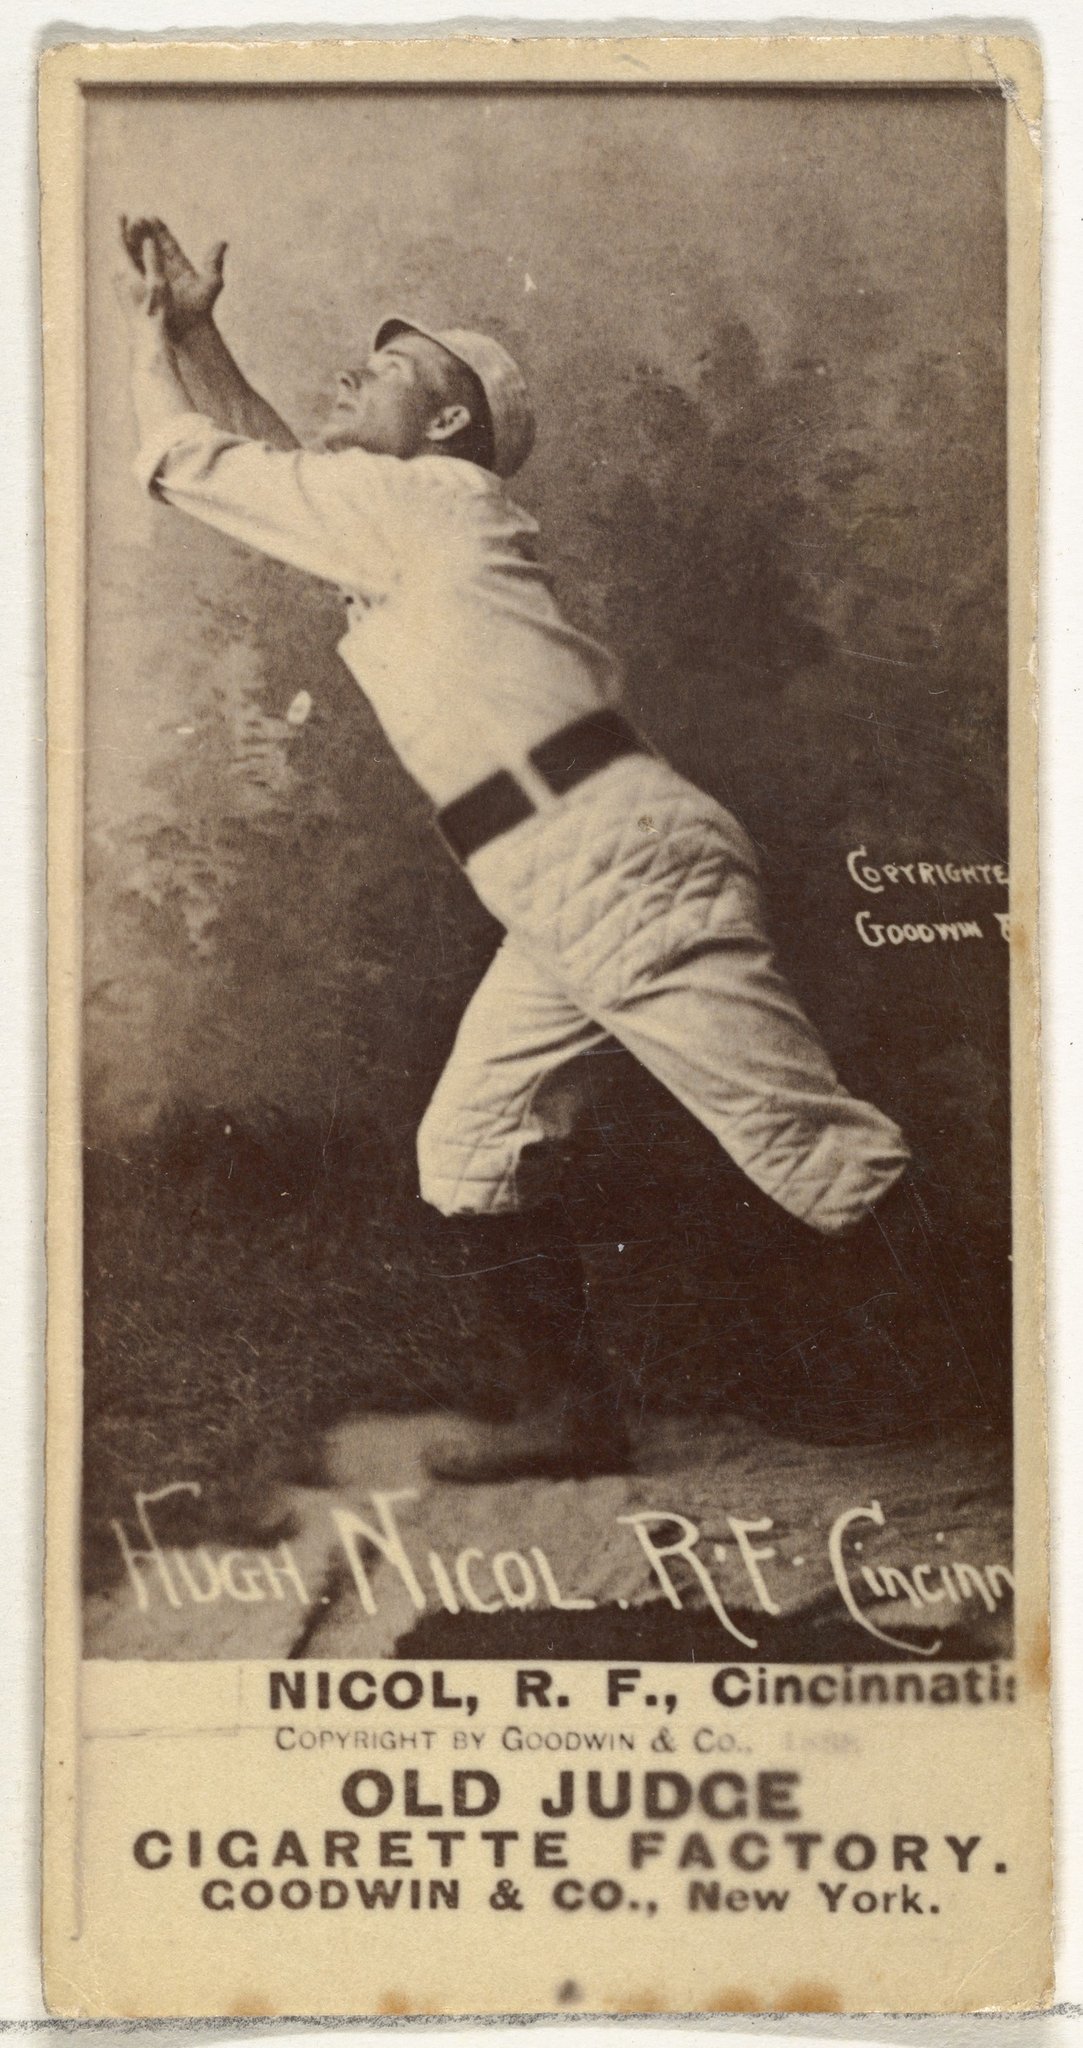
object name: baseball card, photograph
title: Hugh N. "Little Nick" Nicol, Right Field, Cincinnati, from the Old Judge series (N172) for Old Judge Cigarettes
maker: goodwin & company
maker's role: publisher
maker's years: 1850-1950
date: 1888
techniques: albumen silver print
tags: men,portraits,baseball,athletes